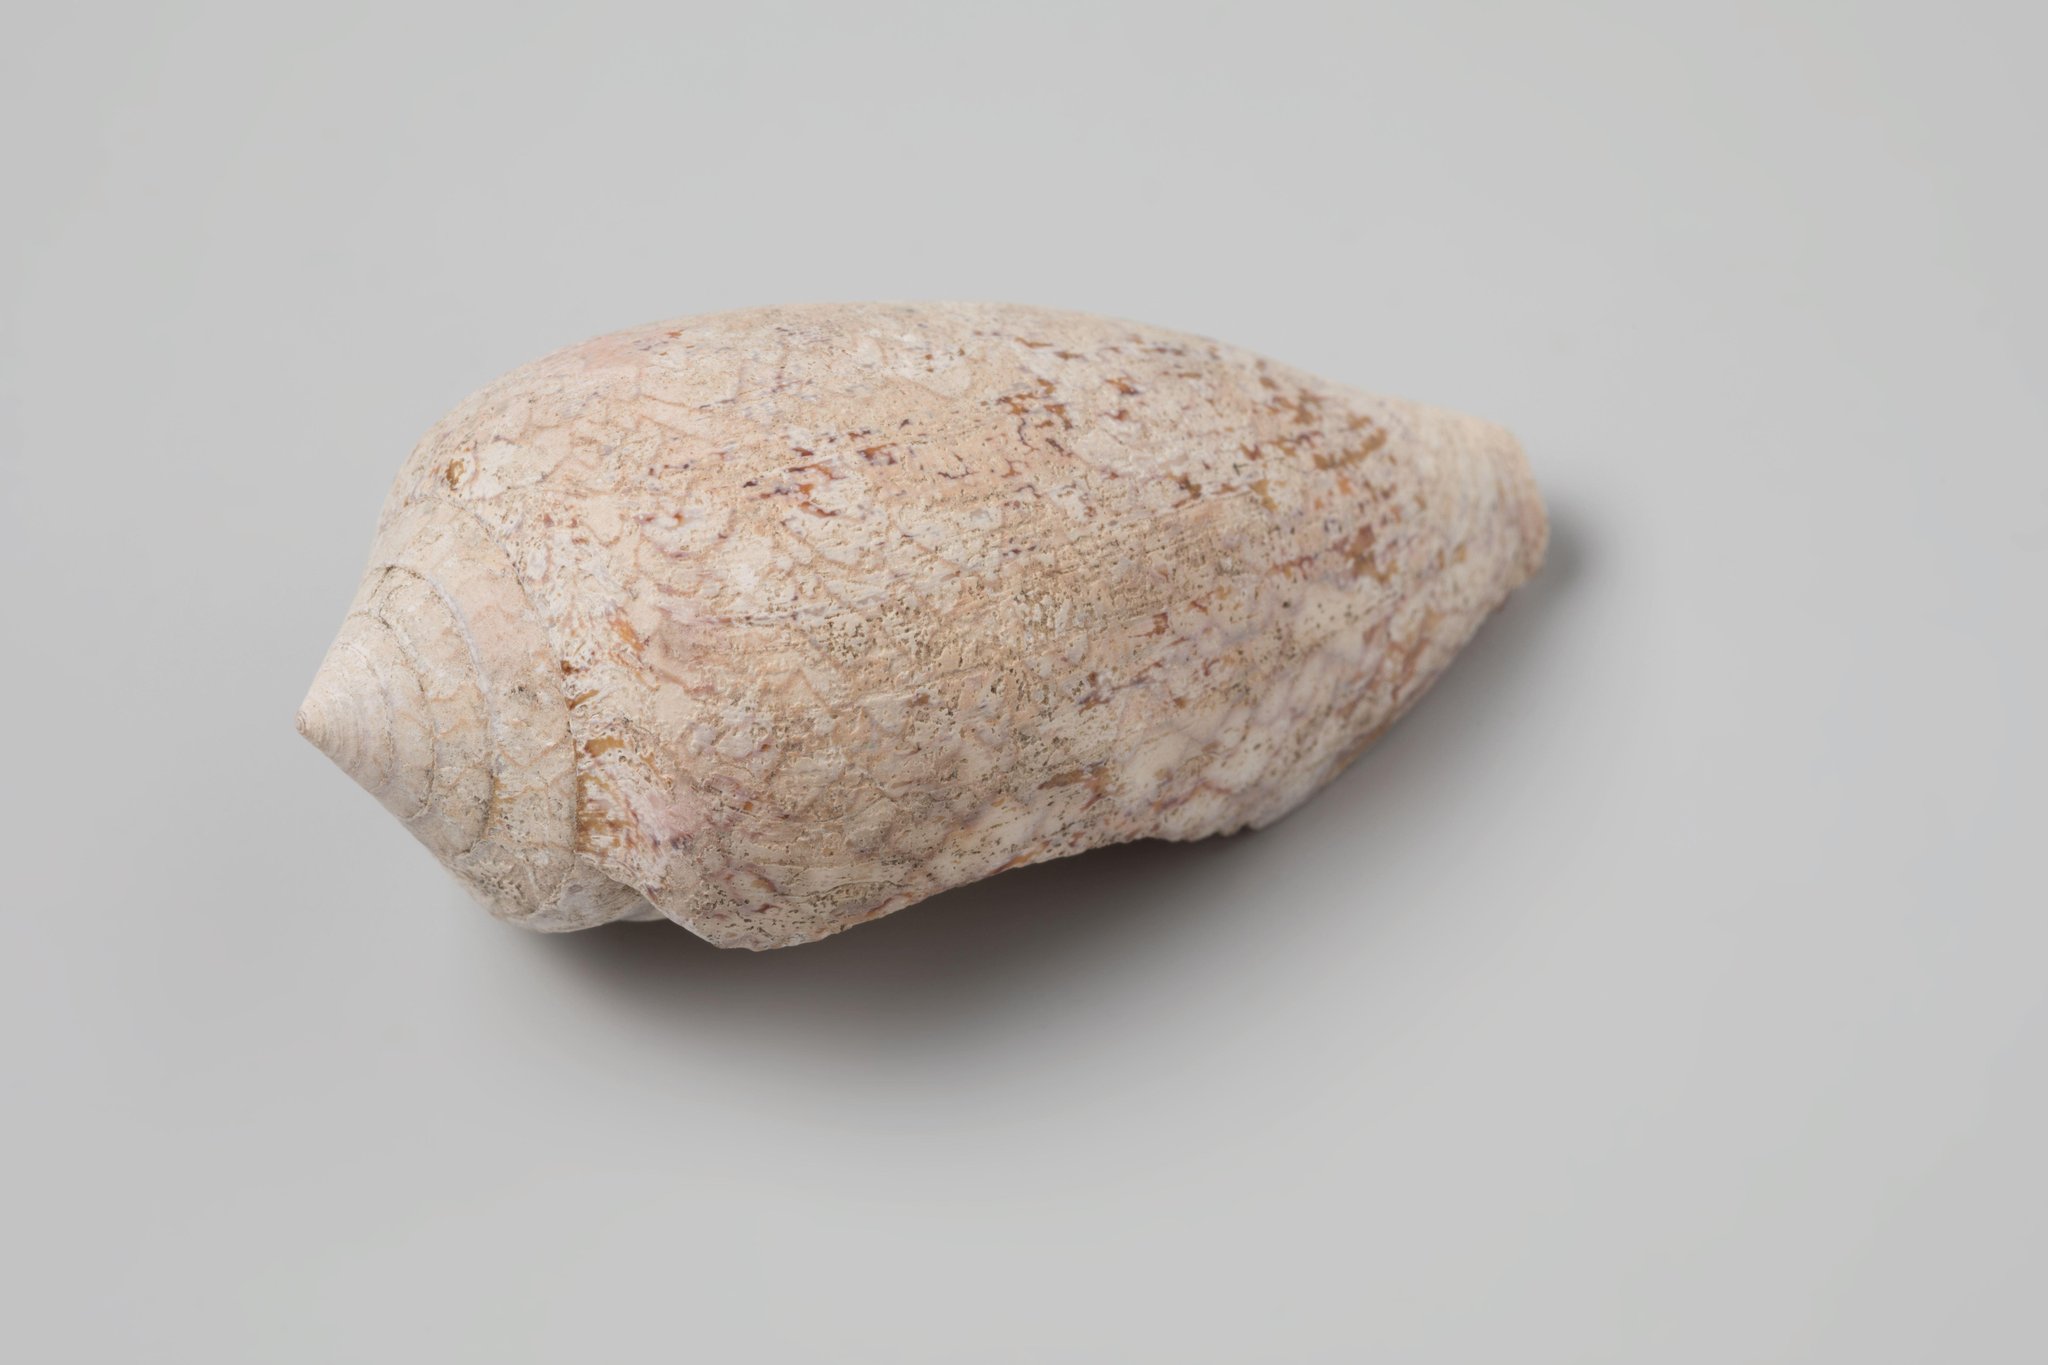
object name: conus textile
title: Conus textile shell from the wreck of the Dutch East India ship Witte Leeuw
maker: niet van toepassing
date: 1613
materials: shell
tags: verenigde oostindische compagnie, sint-helena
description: Schelp uit V.O.C.-schip de 'Witte Leeuw'.